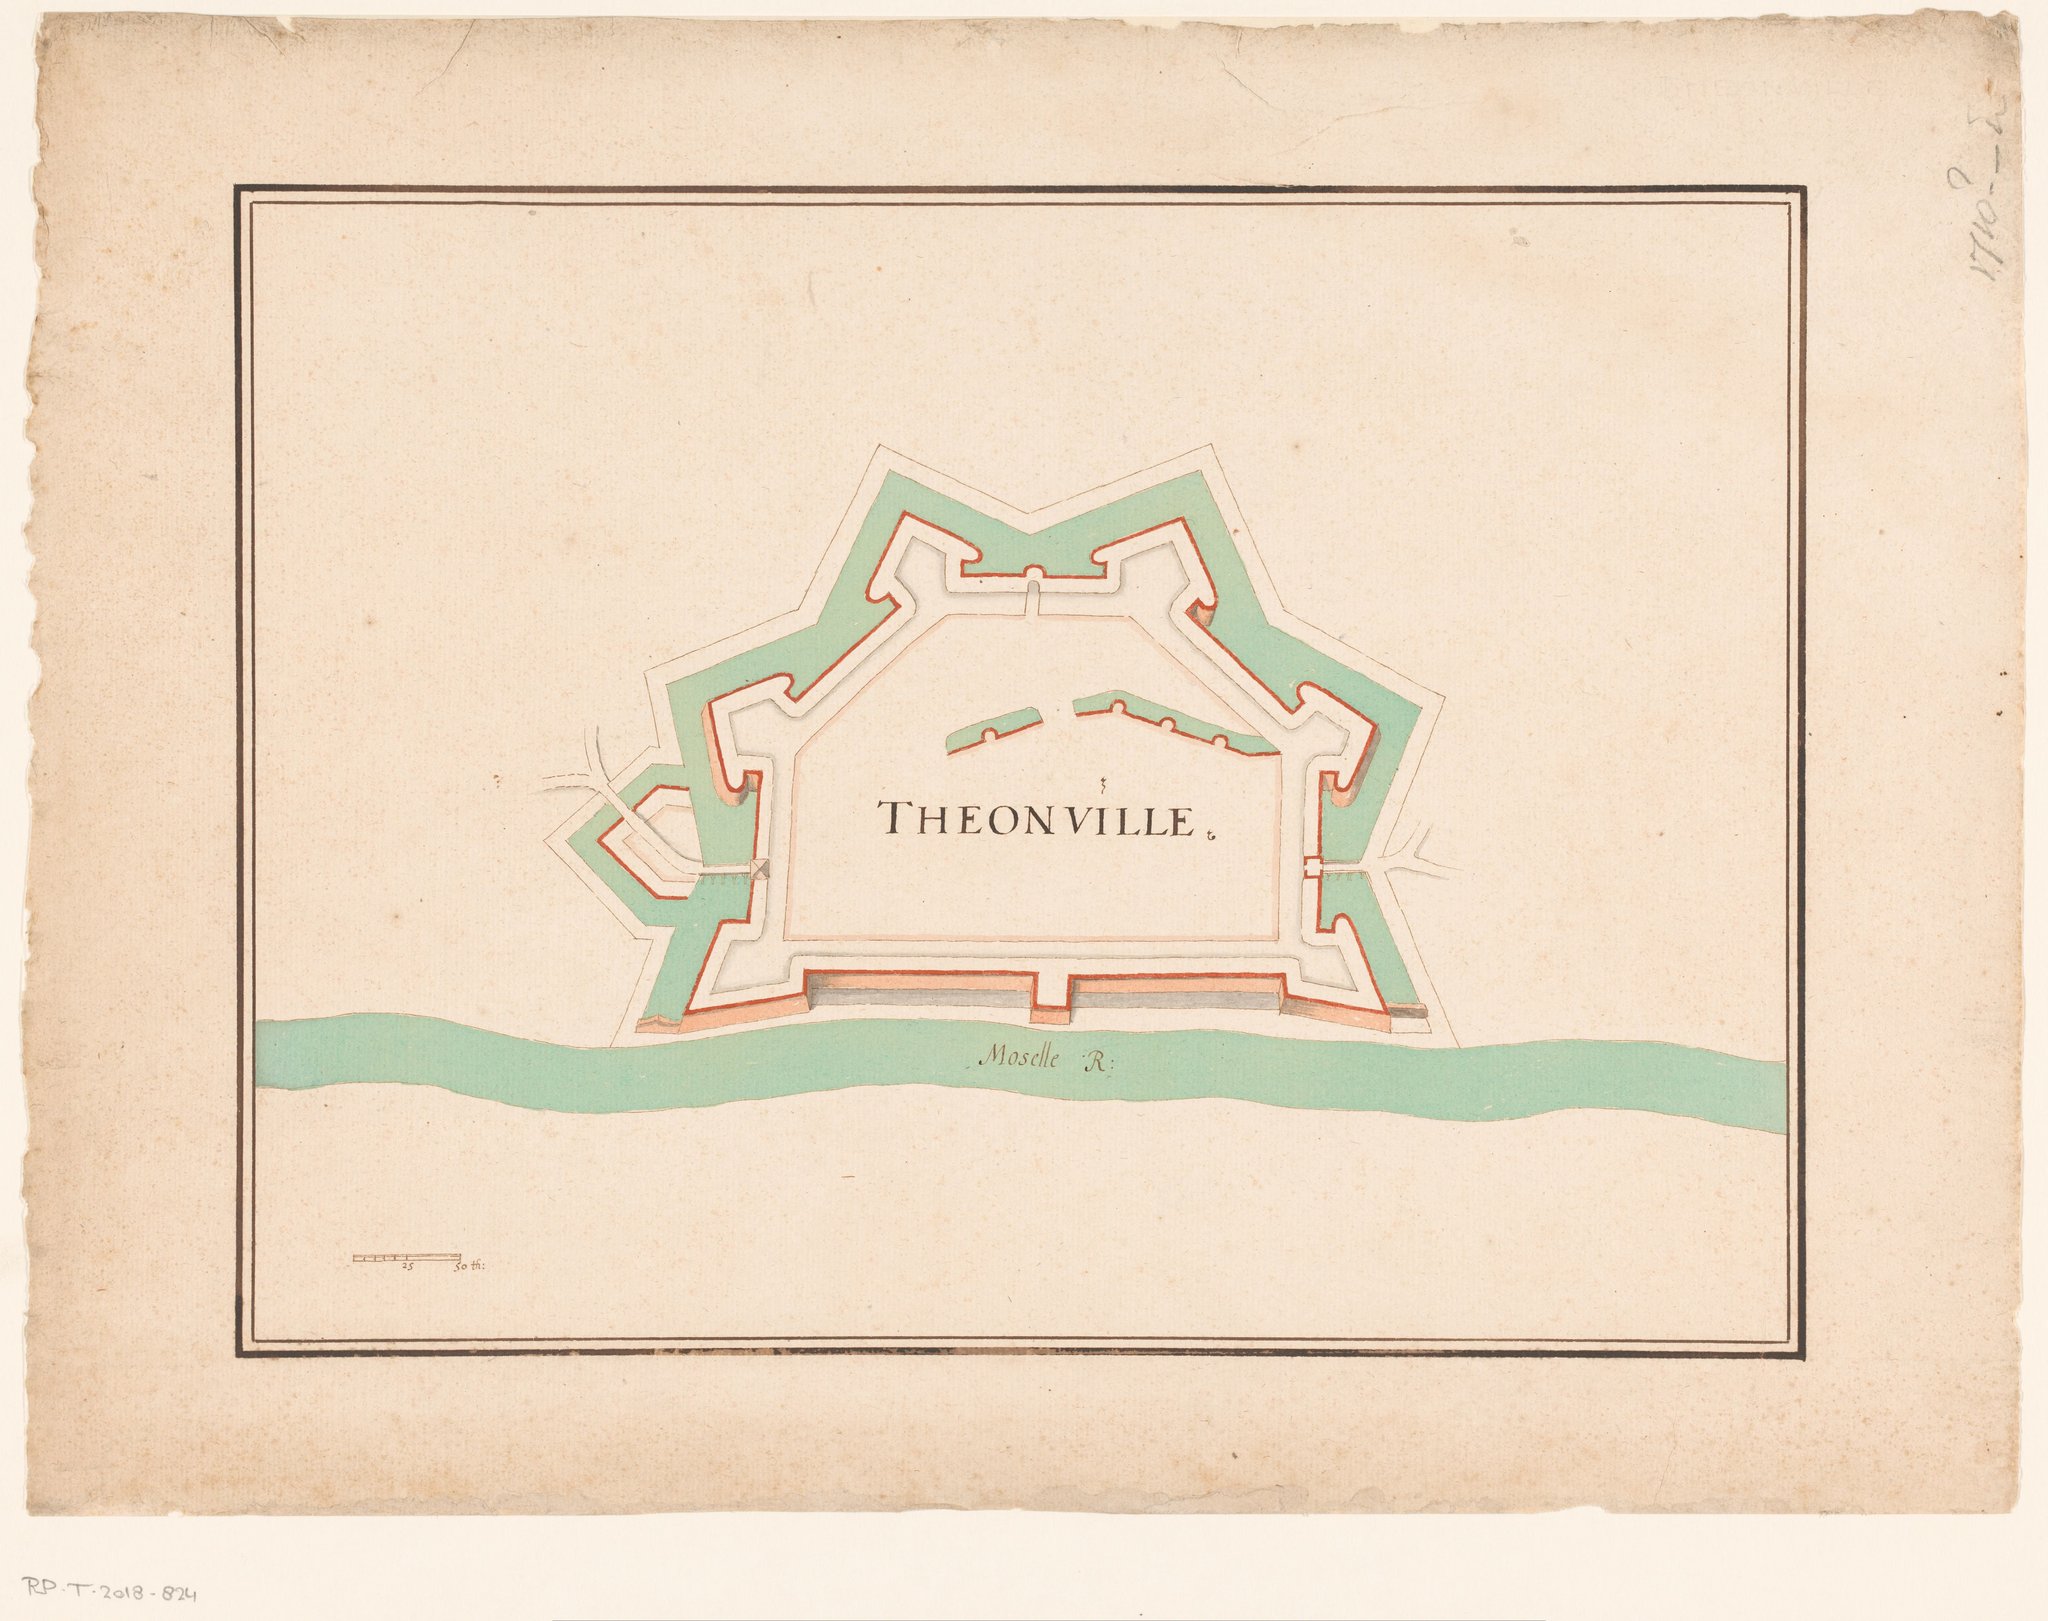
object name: map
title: Wereldkaart met de rezien van James Cook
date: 1780-1796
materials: paper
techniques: engraving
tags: map of the world, exploration, expedition, voyage of discovery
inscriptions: collector's mark: Lugt 2228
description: Wereldkaart met daarop de reizen van James Cook aangegeven. De kaart is voorzien van een zoekrooster en een gradenverdeling langs de randen. Rechtsonder een legenda.